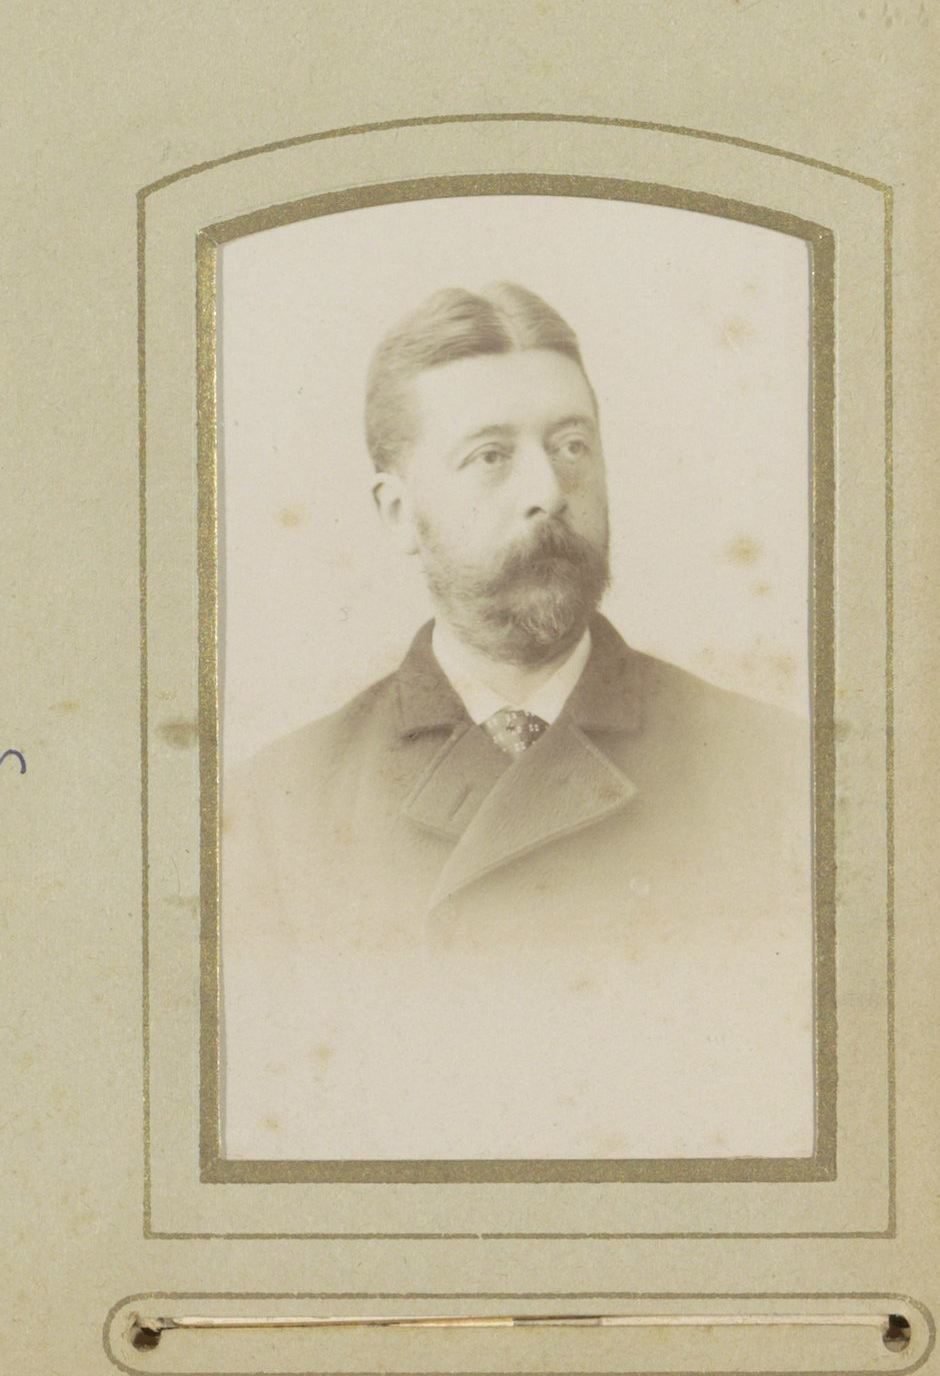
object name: photograph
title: Portret van Hein Waller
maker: max büttinghausen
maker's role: fotograaf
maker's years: 1847-1906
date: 1886-1906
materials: cardboard, paper, photographic support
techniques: albumen print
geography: amsterdam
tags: adult man, historical persons, amsterdam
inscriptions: address: ‘Amsterdam Kalverstraat, hoek Spui’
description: Onderdeel van Fotoalbum van de familie Boelen.